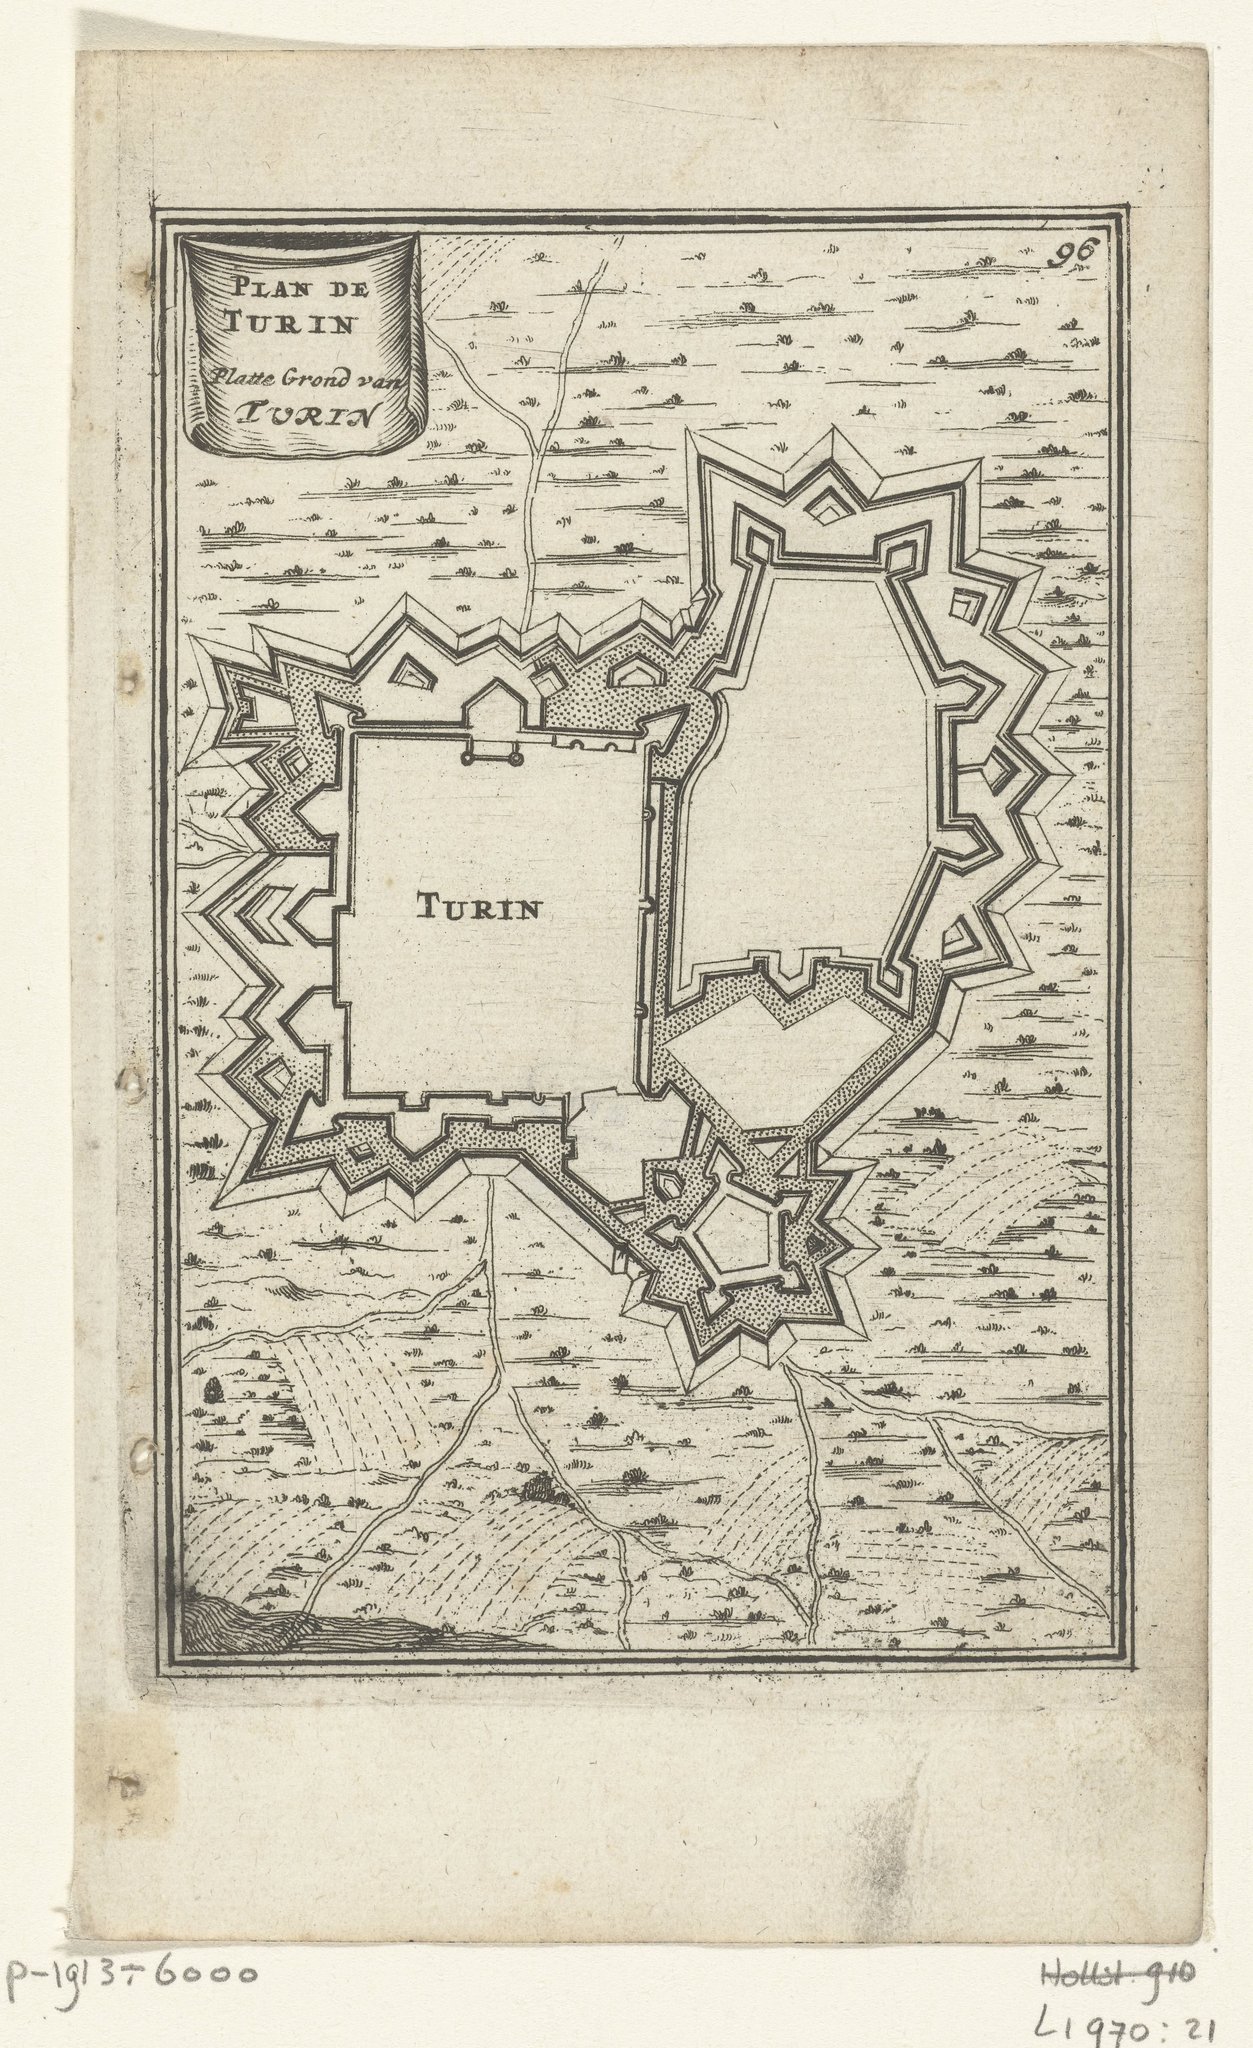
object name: print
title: Portret van Eberhard Julius von Massow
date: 1806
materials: paper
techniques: stippling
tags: historical persons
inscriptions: collector's mark: Lugt 2228